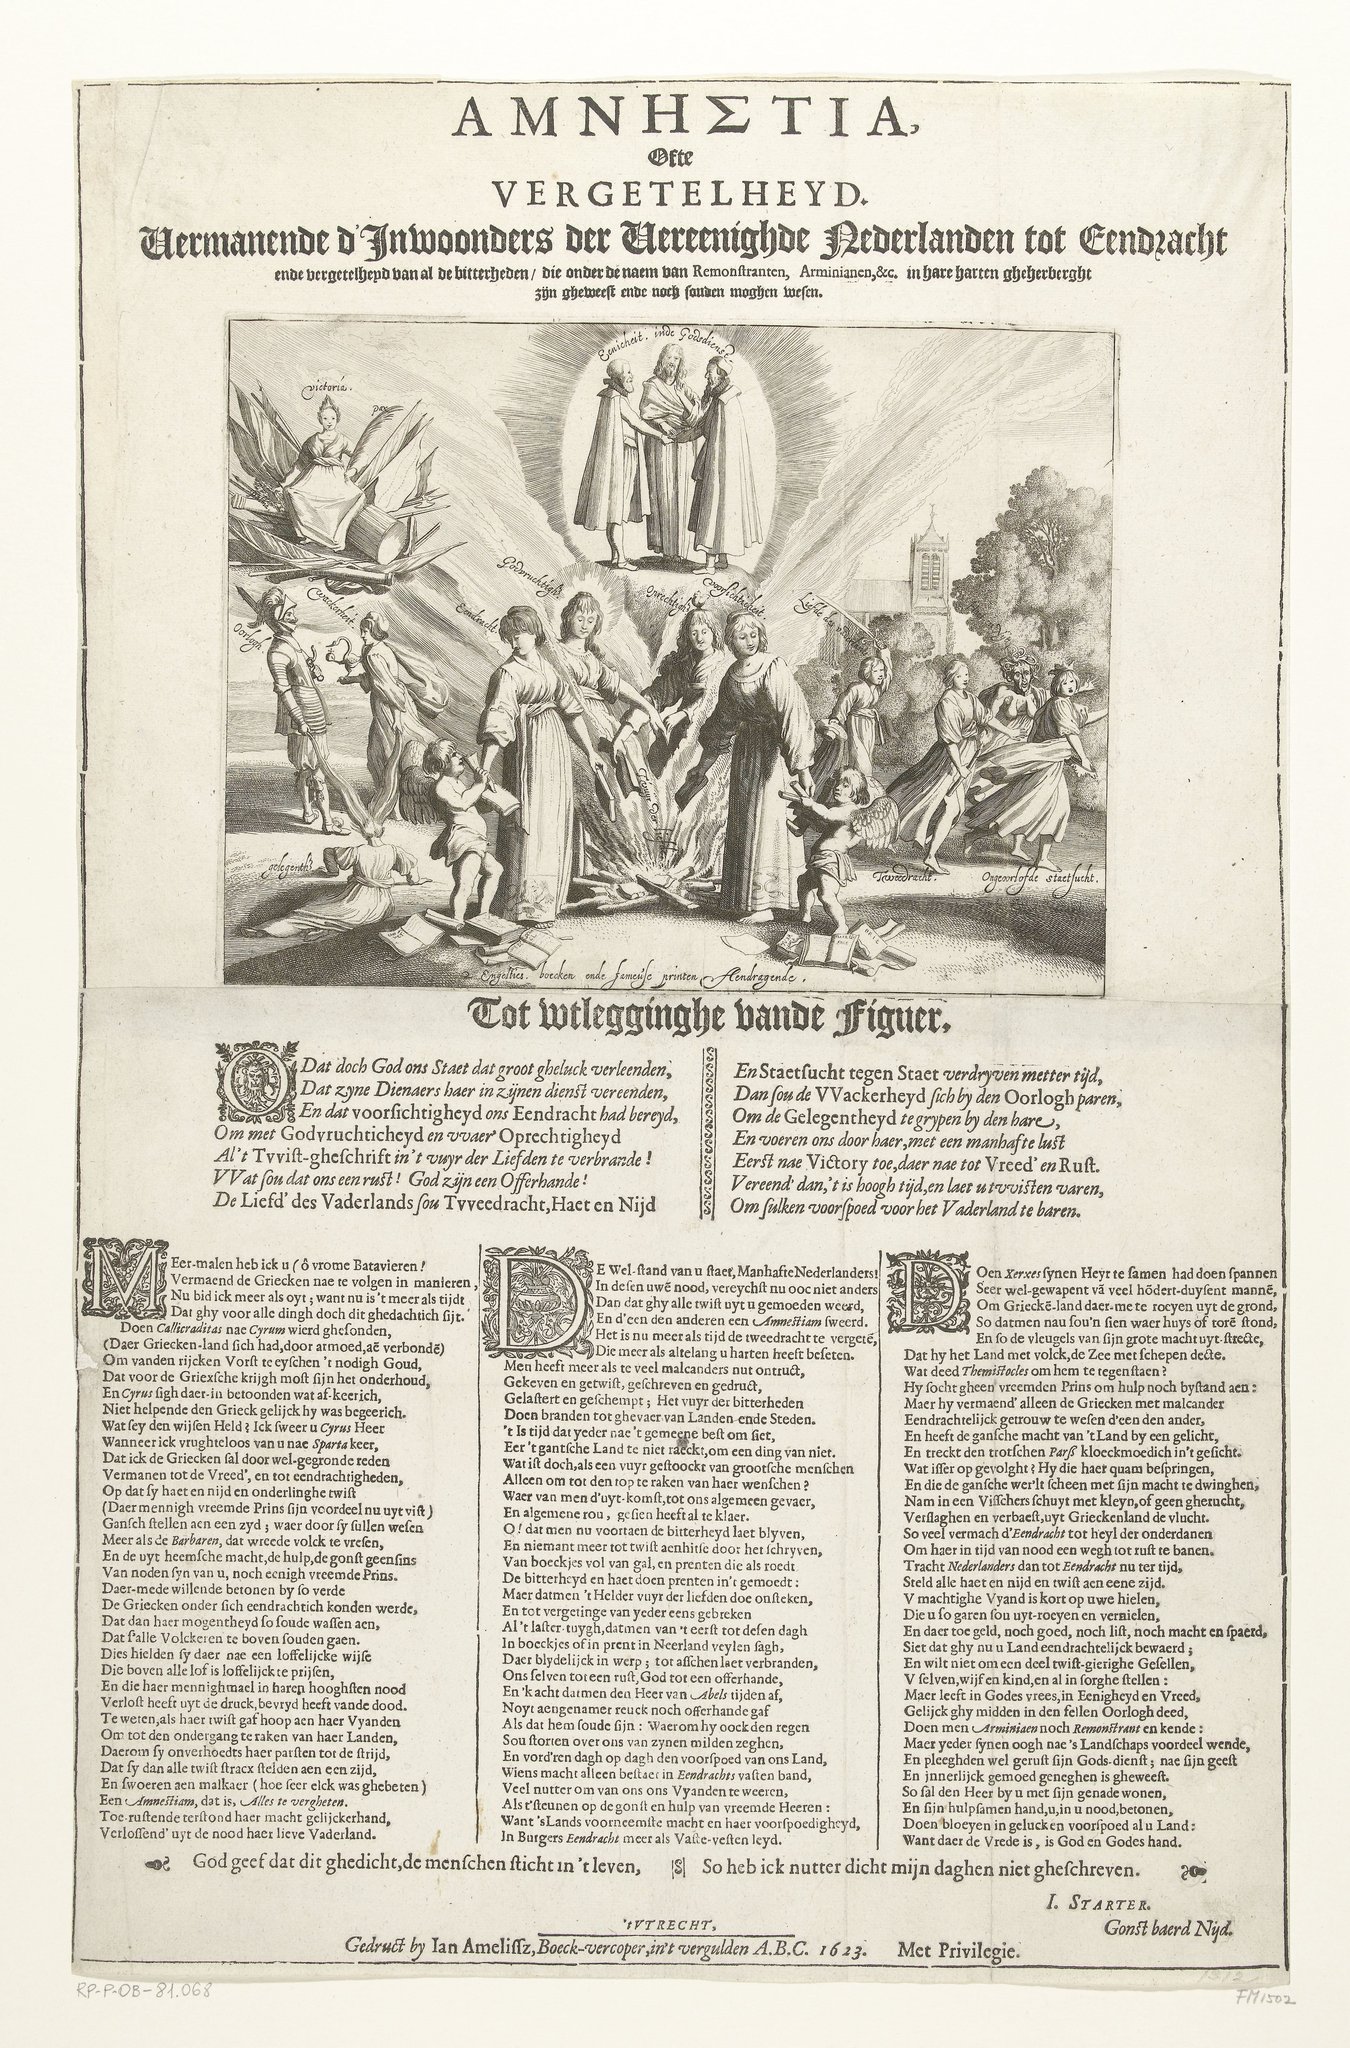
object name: print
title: Amnestia, Ofte Vergetelheyd. Vermanende d'Inwoonders der Vereenighde Nederlanden tot Eendracht ende vergetelheyd van al de bitterheden / die onder de naem van Remonstranten, Arminianen, &c. in hare harten gheherberght zijn gheweest ende noch souden moghen wesen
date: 1623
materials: paper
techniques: etching, letterpress printing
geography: utrecht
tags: agreement, unity; 'concordia', 'concordia insuperabile', 'concordia militare', 'concordia di pace', 'unione civile' (ripa), reconciliation ~ diplomacy, reconciliation, burning of books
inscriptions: date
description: Blad met een allegorische voorstelling en twee verzen waarin gepleit wordt voor eensgezindheid, eendracht en verzoening tussen de godsdiensten in de Verenigde Nederlanden, 1623. Vier personificaties van Eendracht, Godvruchtigheid, Oprechtheid en Voorzichtigheid verbranden in het Vuur van de Liefde opruiende boeken, pamfletten en prenten die door engeltjes aangedragen worden. Rechts verdrijft Liefde des Vaderlands Tweedracht en Ongeoorloofde Staatszucht. Links sleuren Oorlog en Waakzaamheid de personificatie aangeduid als Gelegenheid aan het haar. Bovenaan verzoent Christus twee aanhangers van verschillende godsdiensten met elkaar. Onder de prent geplakt een blad met een uitleg van de voorstelling in versvorm in 2 en 3 kolommen in het Nederlands.